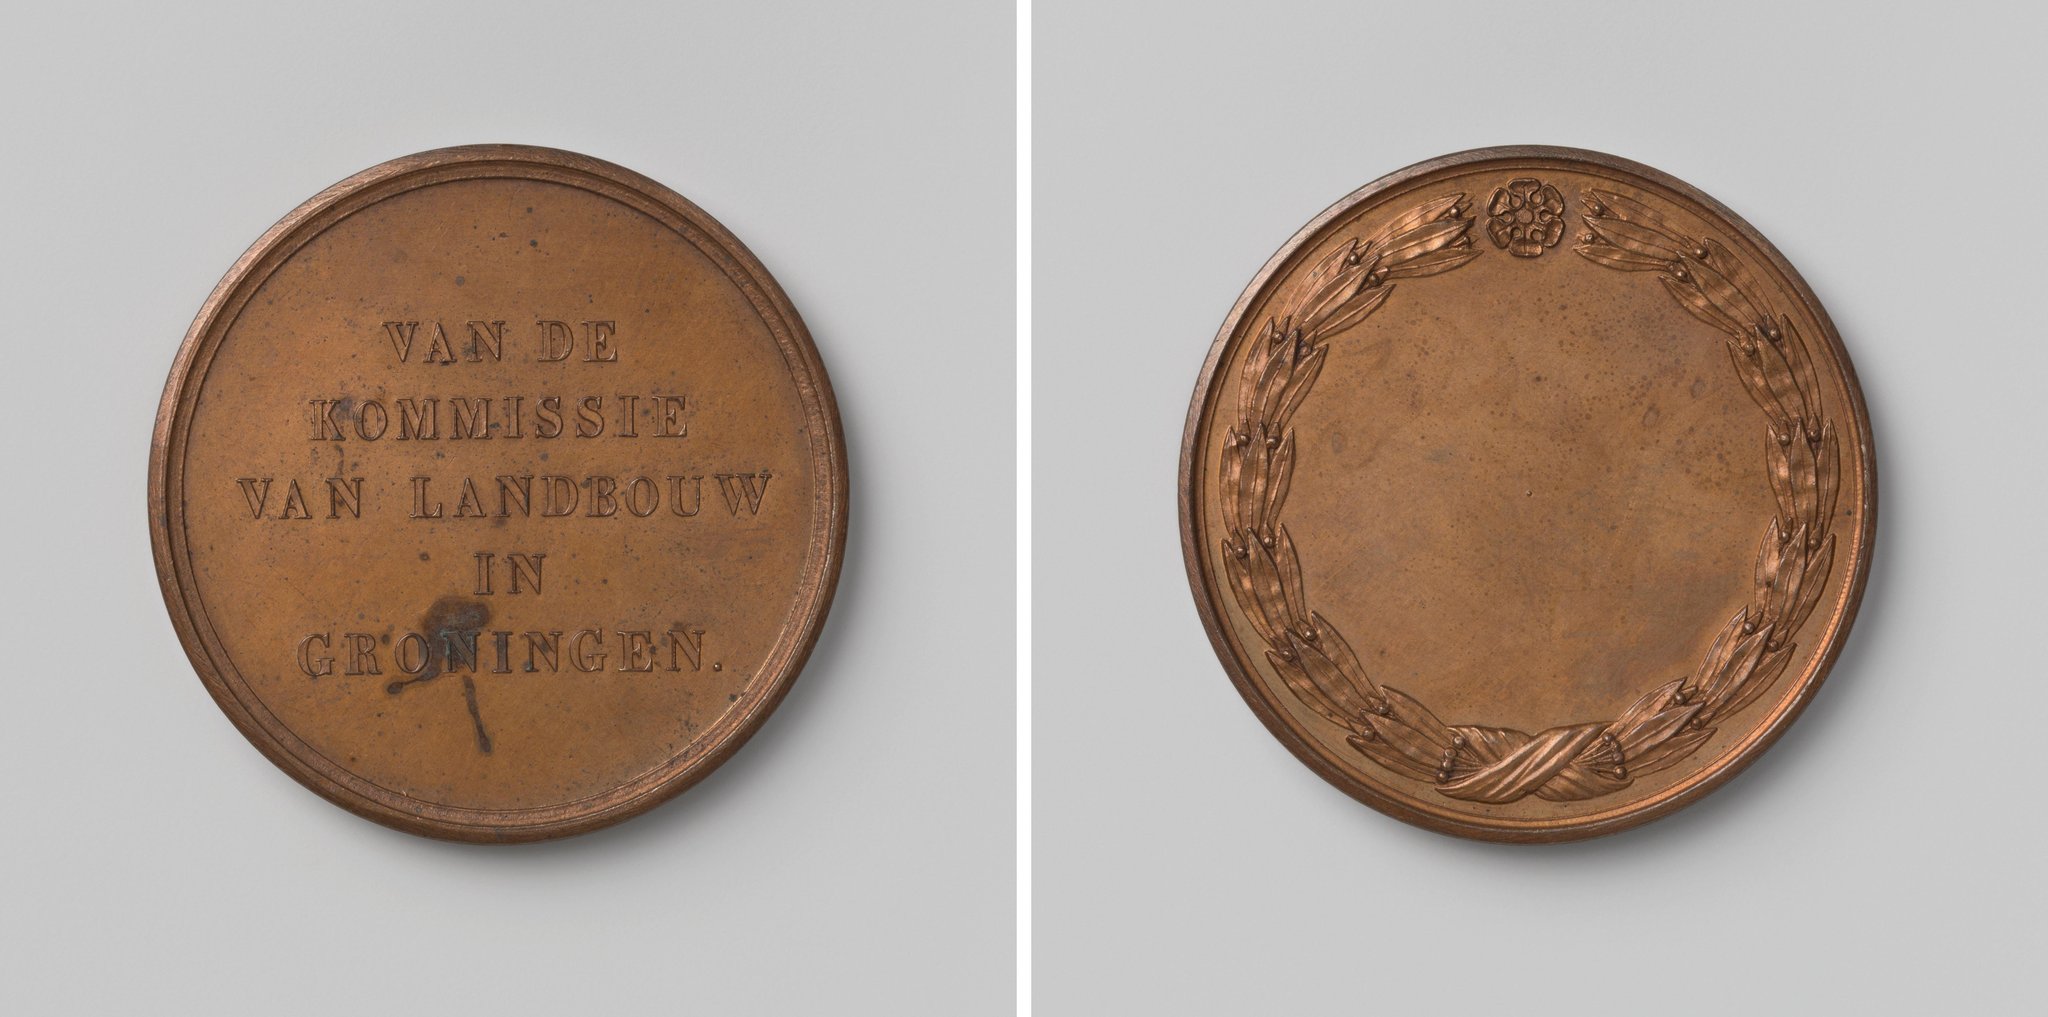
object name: medal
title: Commissie van Landbouw in Groningen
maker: Anonymous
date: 1800-1875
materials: bronze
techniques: striking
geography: netherlands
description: Bronzen penning. Voorzijde: opschrift. Keerzijde: blanco veld binnen krans van myrteloof